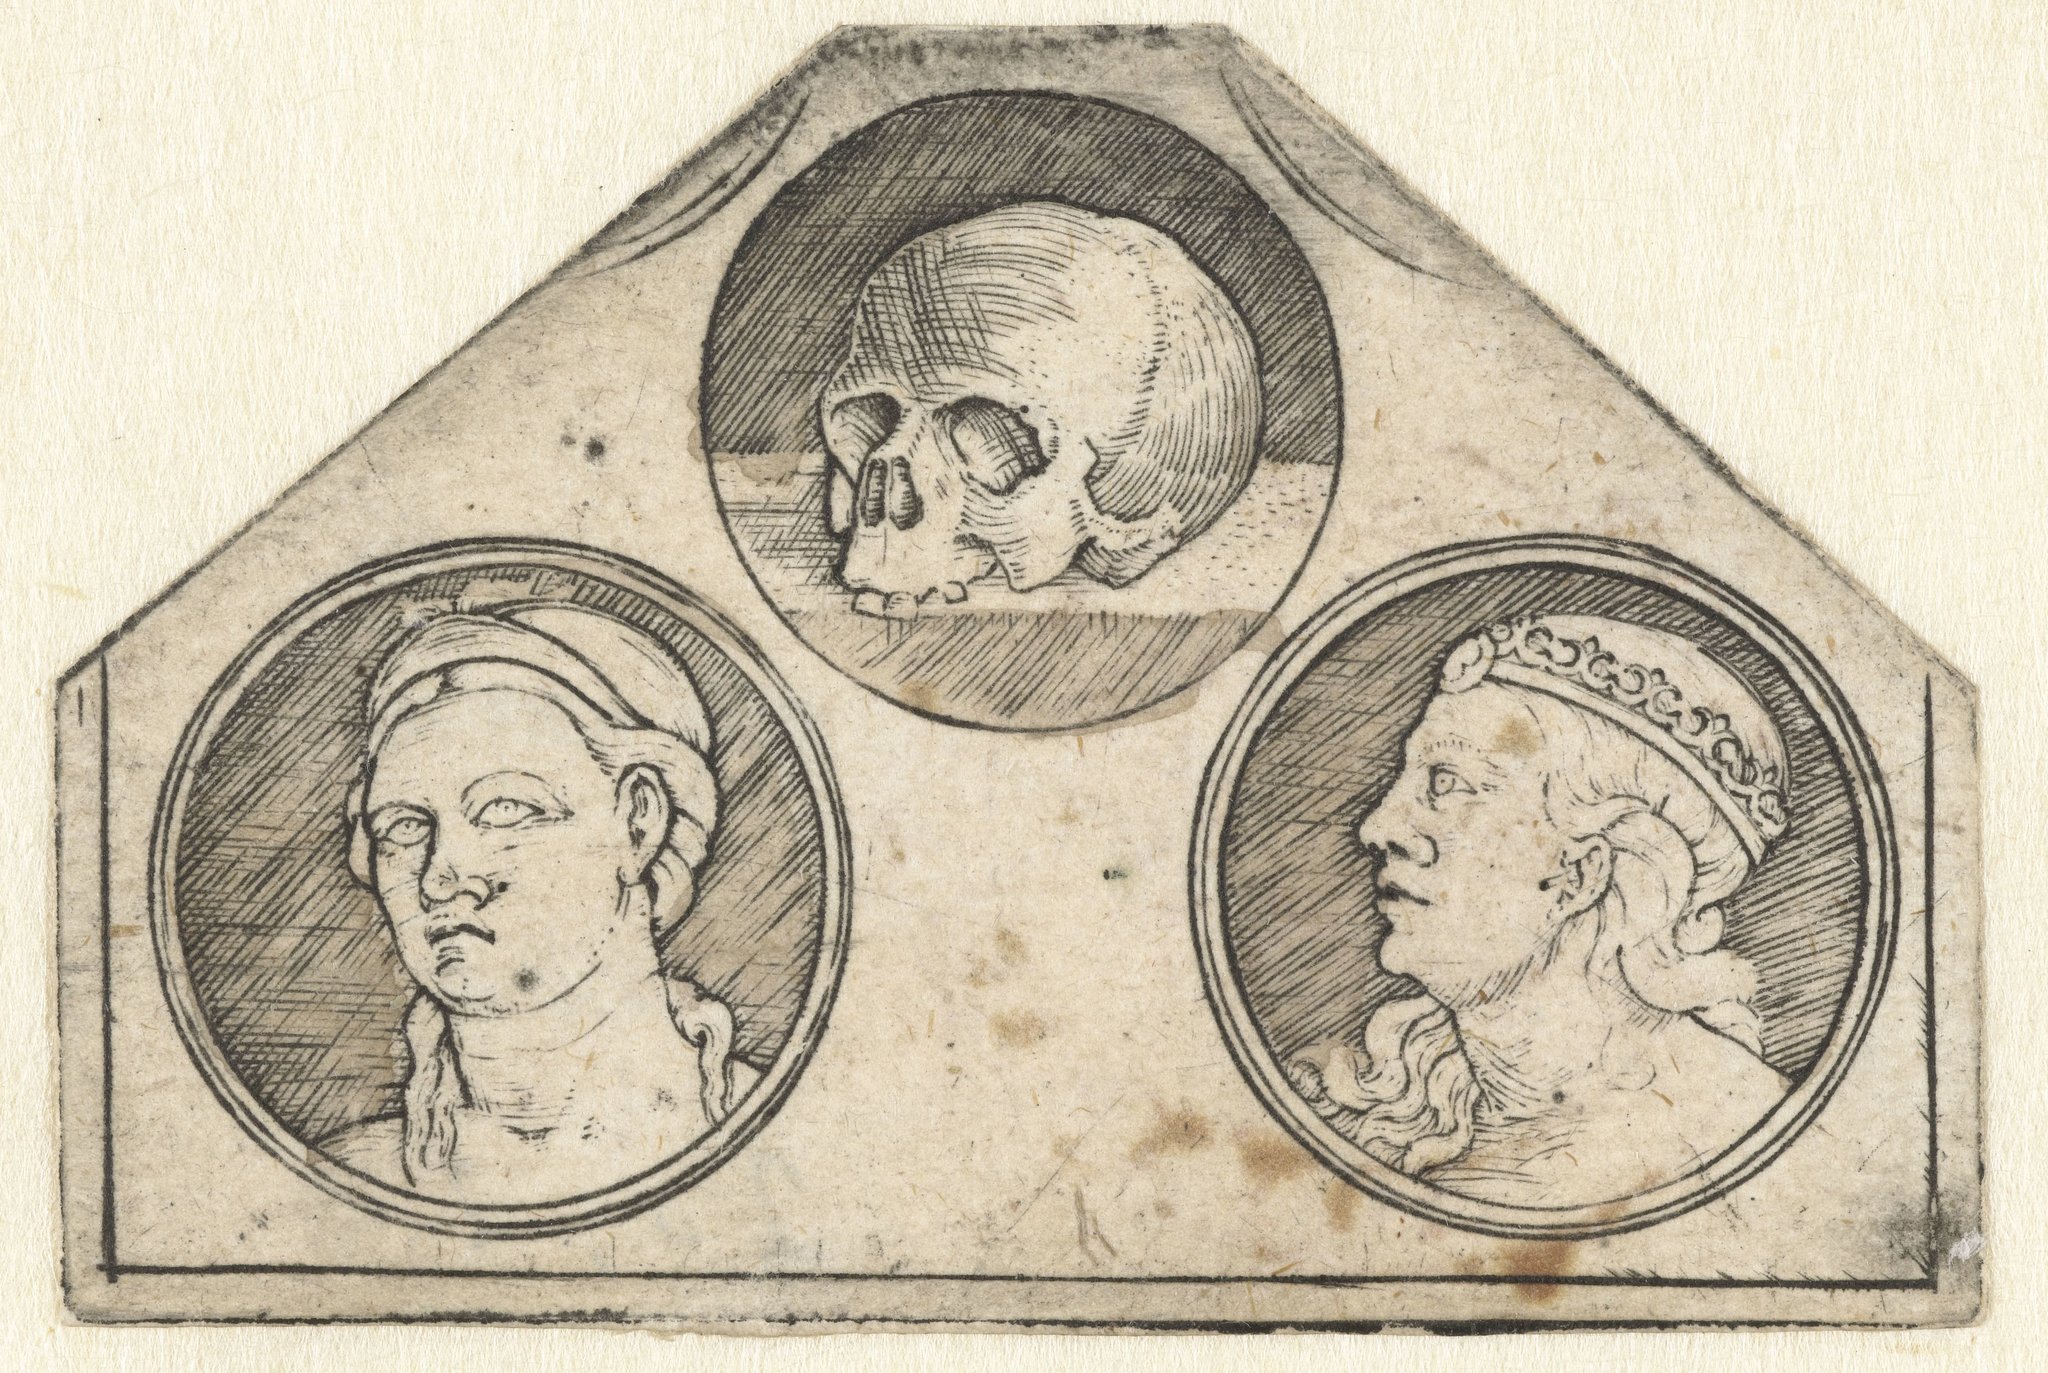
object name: print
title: Blad met drie ronde voorstellingen: schedel en twee hoofden van vrouwen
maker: Anonymous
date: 1500-1599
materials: paper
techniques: engraving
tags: head (human), death's head, skull (symbol of death)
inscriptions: collector's mark: Lugt 240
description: Afdruk van een fragment van een etsplaat op zeshoekig formaat, bovenaan zijn nog lijnen zichtbaar van twee andere ronde voorstellingen op de oorspronklijke plaat.